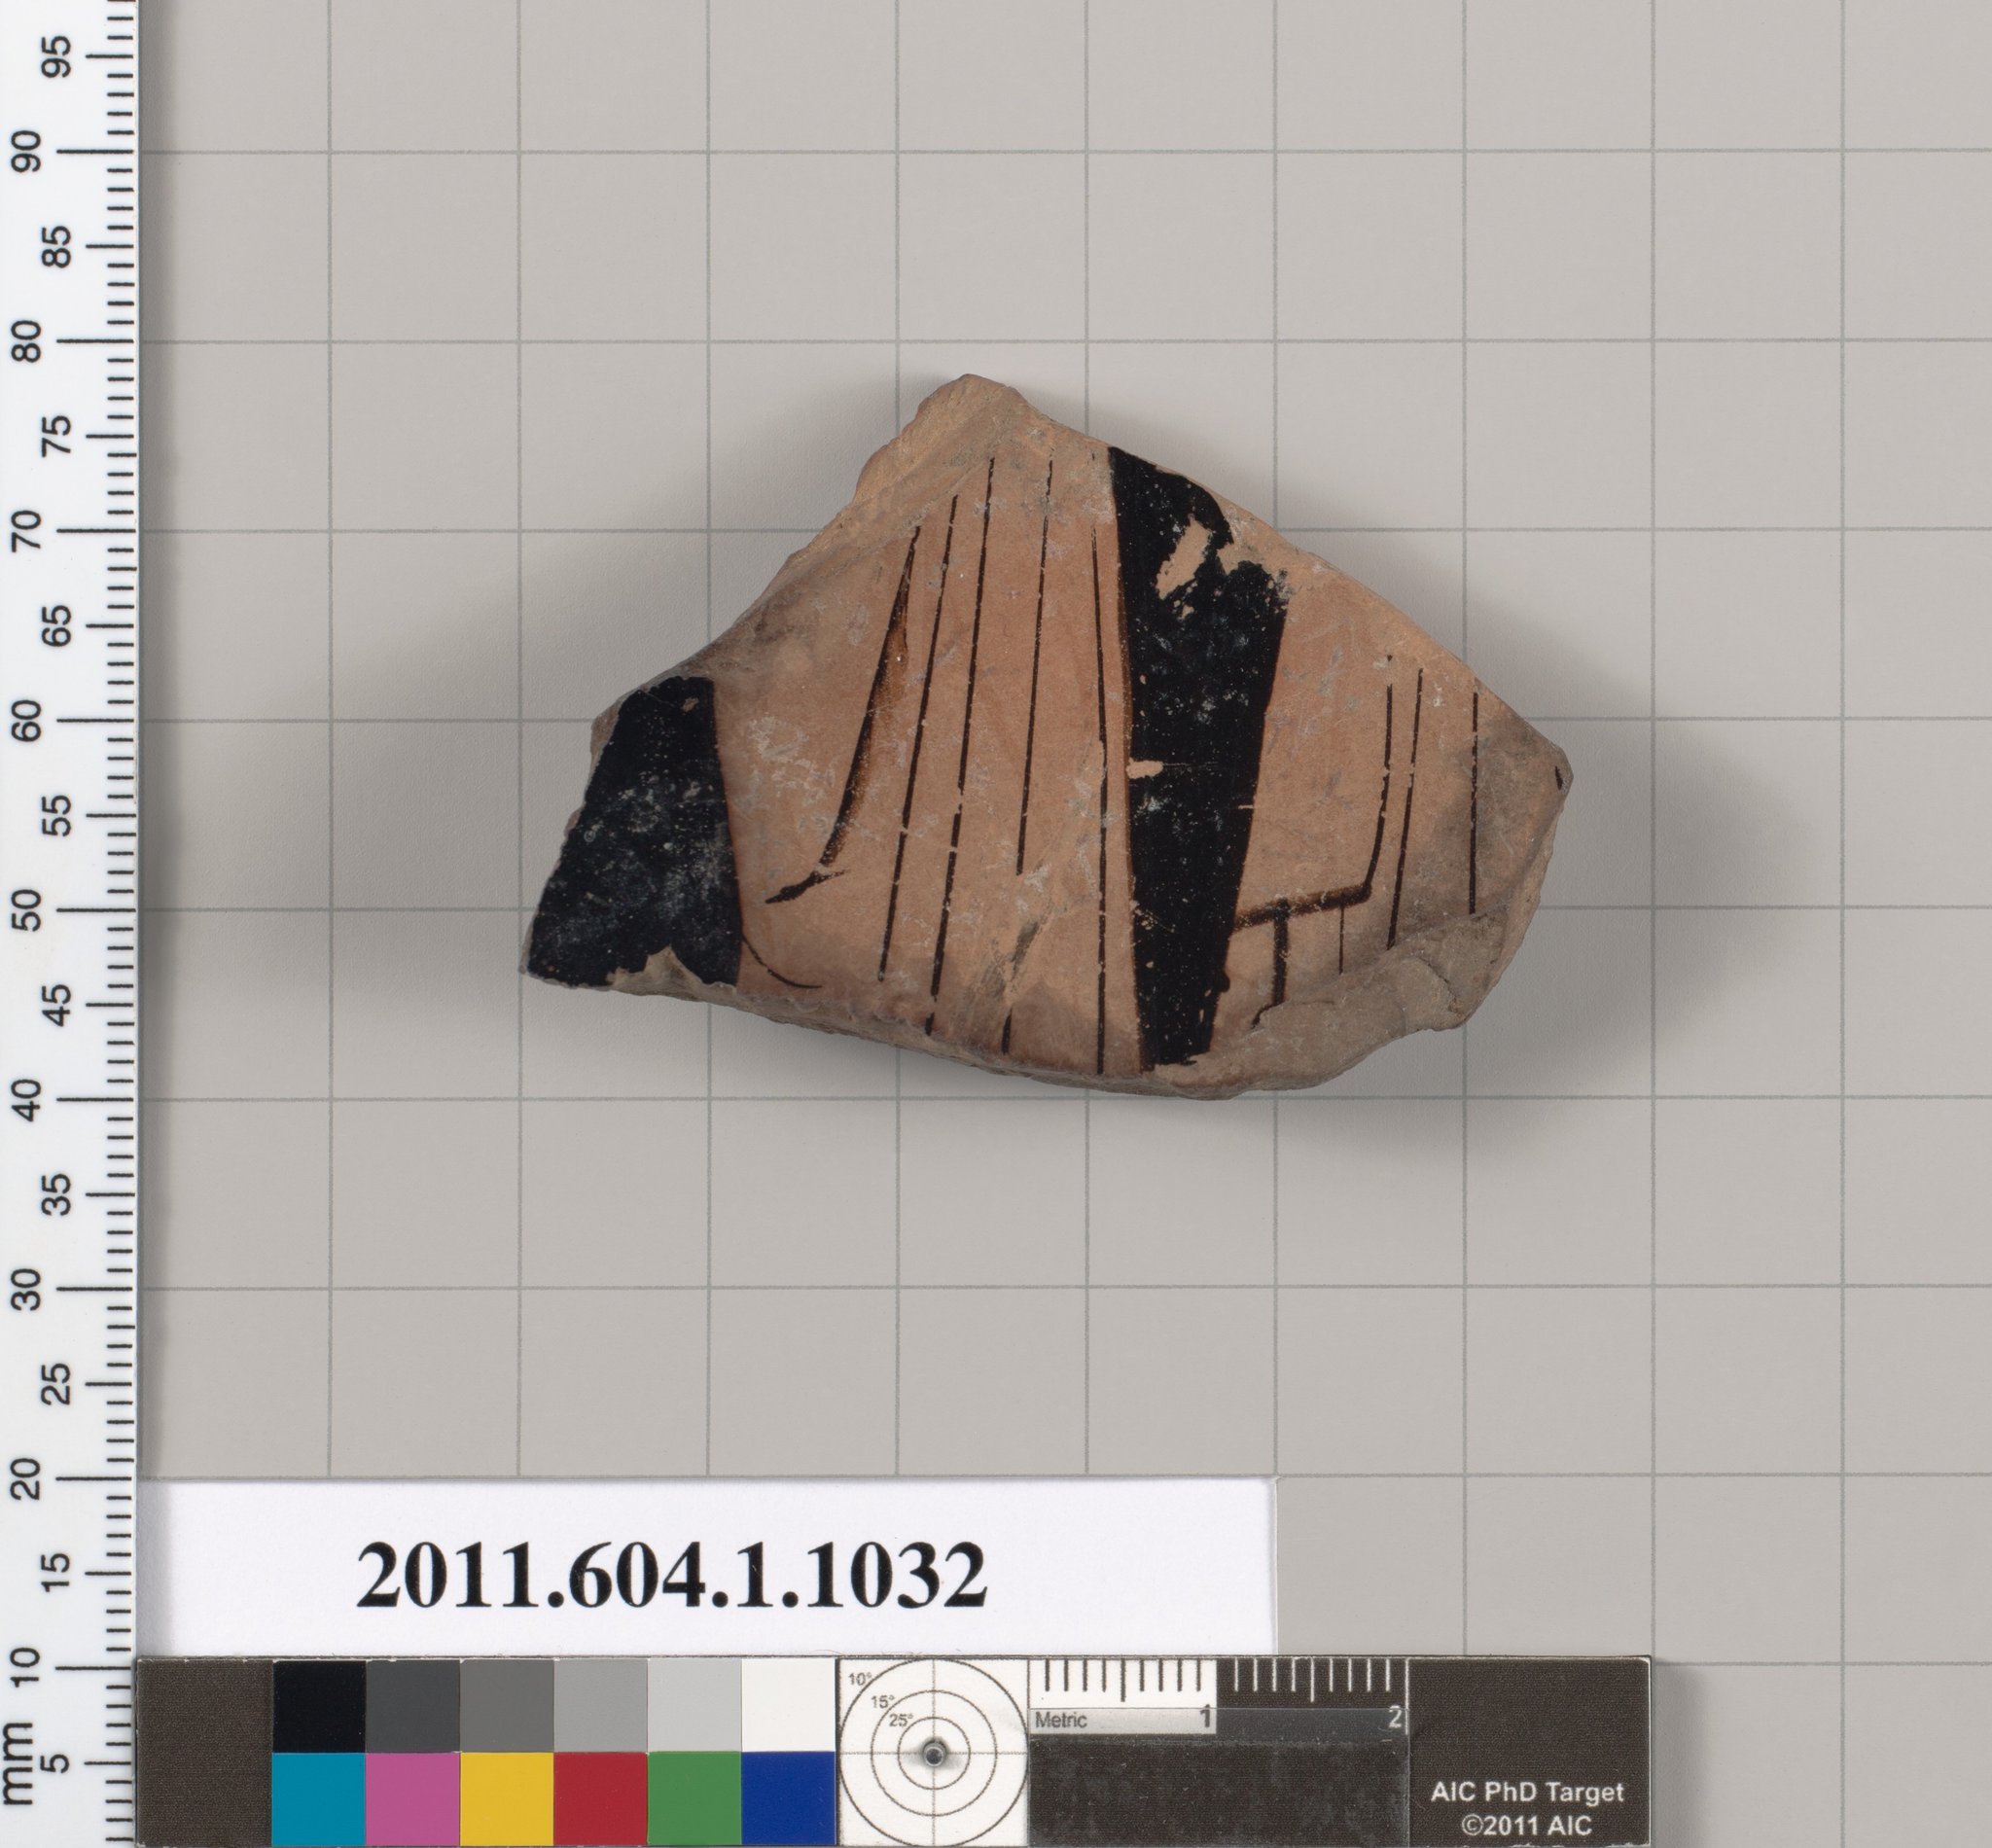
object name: kylix fragment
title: Terracotta fragment of a kylix (drinking cup)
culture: greek, attic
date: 475-451 BCE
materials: terracotta